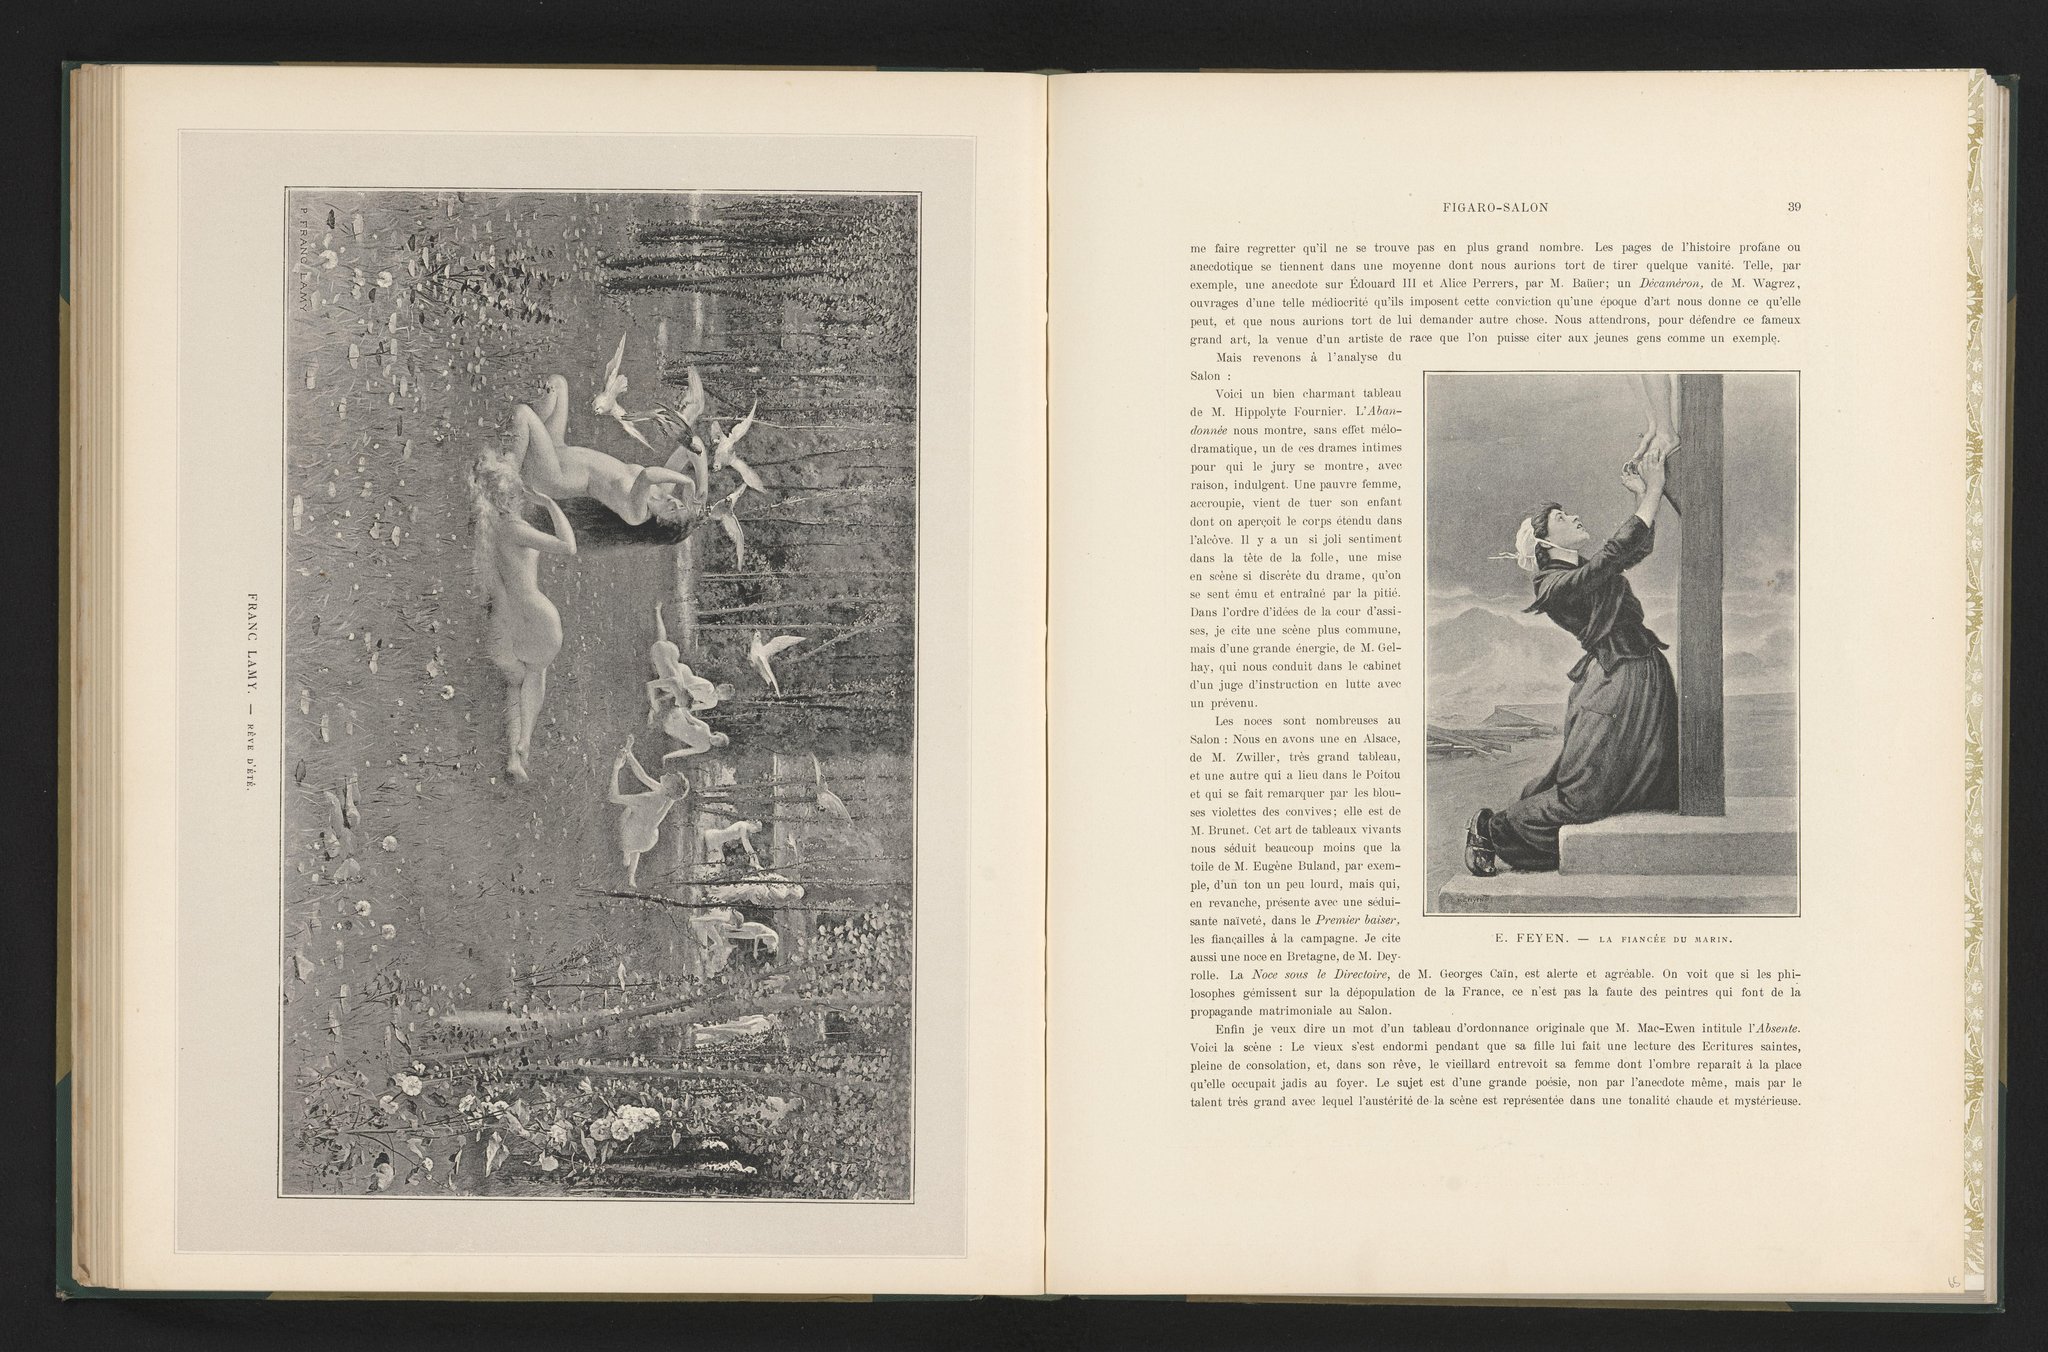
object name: page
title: Reproductie van een schilderij van een tuin met naakte vrouwen liggend in het gras door Pierre Franc Lamy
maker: Anonymous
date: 1885-1901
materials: paper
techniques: autotype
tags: garden, the (nude) human figure; 'corpo humano' (ripa) - aa - female human figure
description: Prent op pagina 38 van Figaro-Salon (par Albert Wolff).